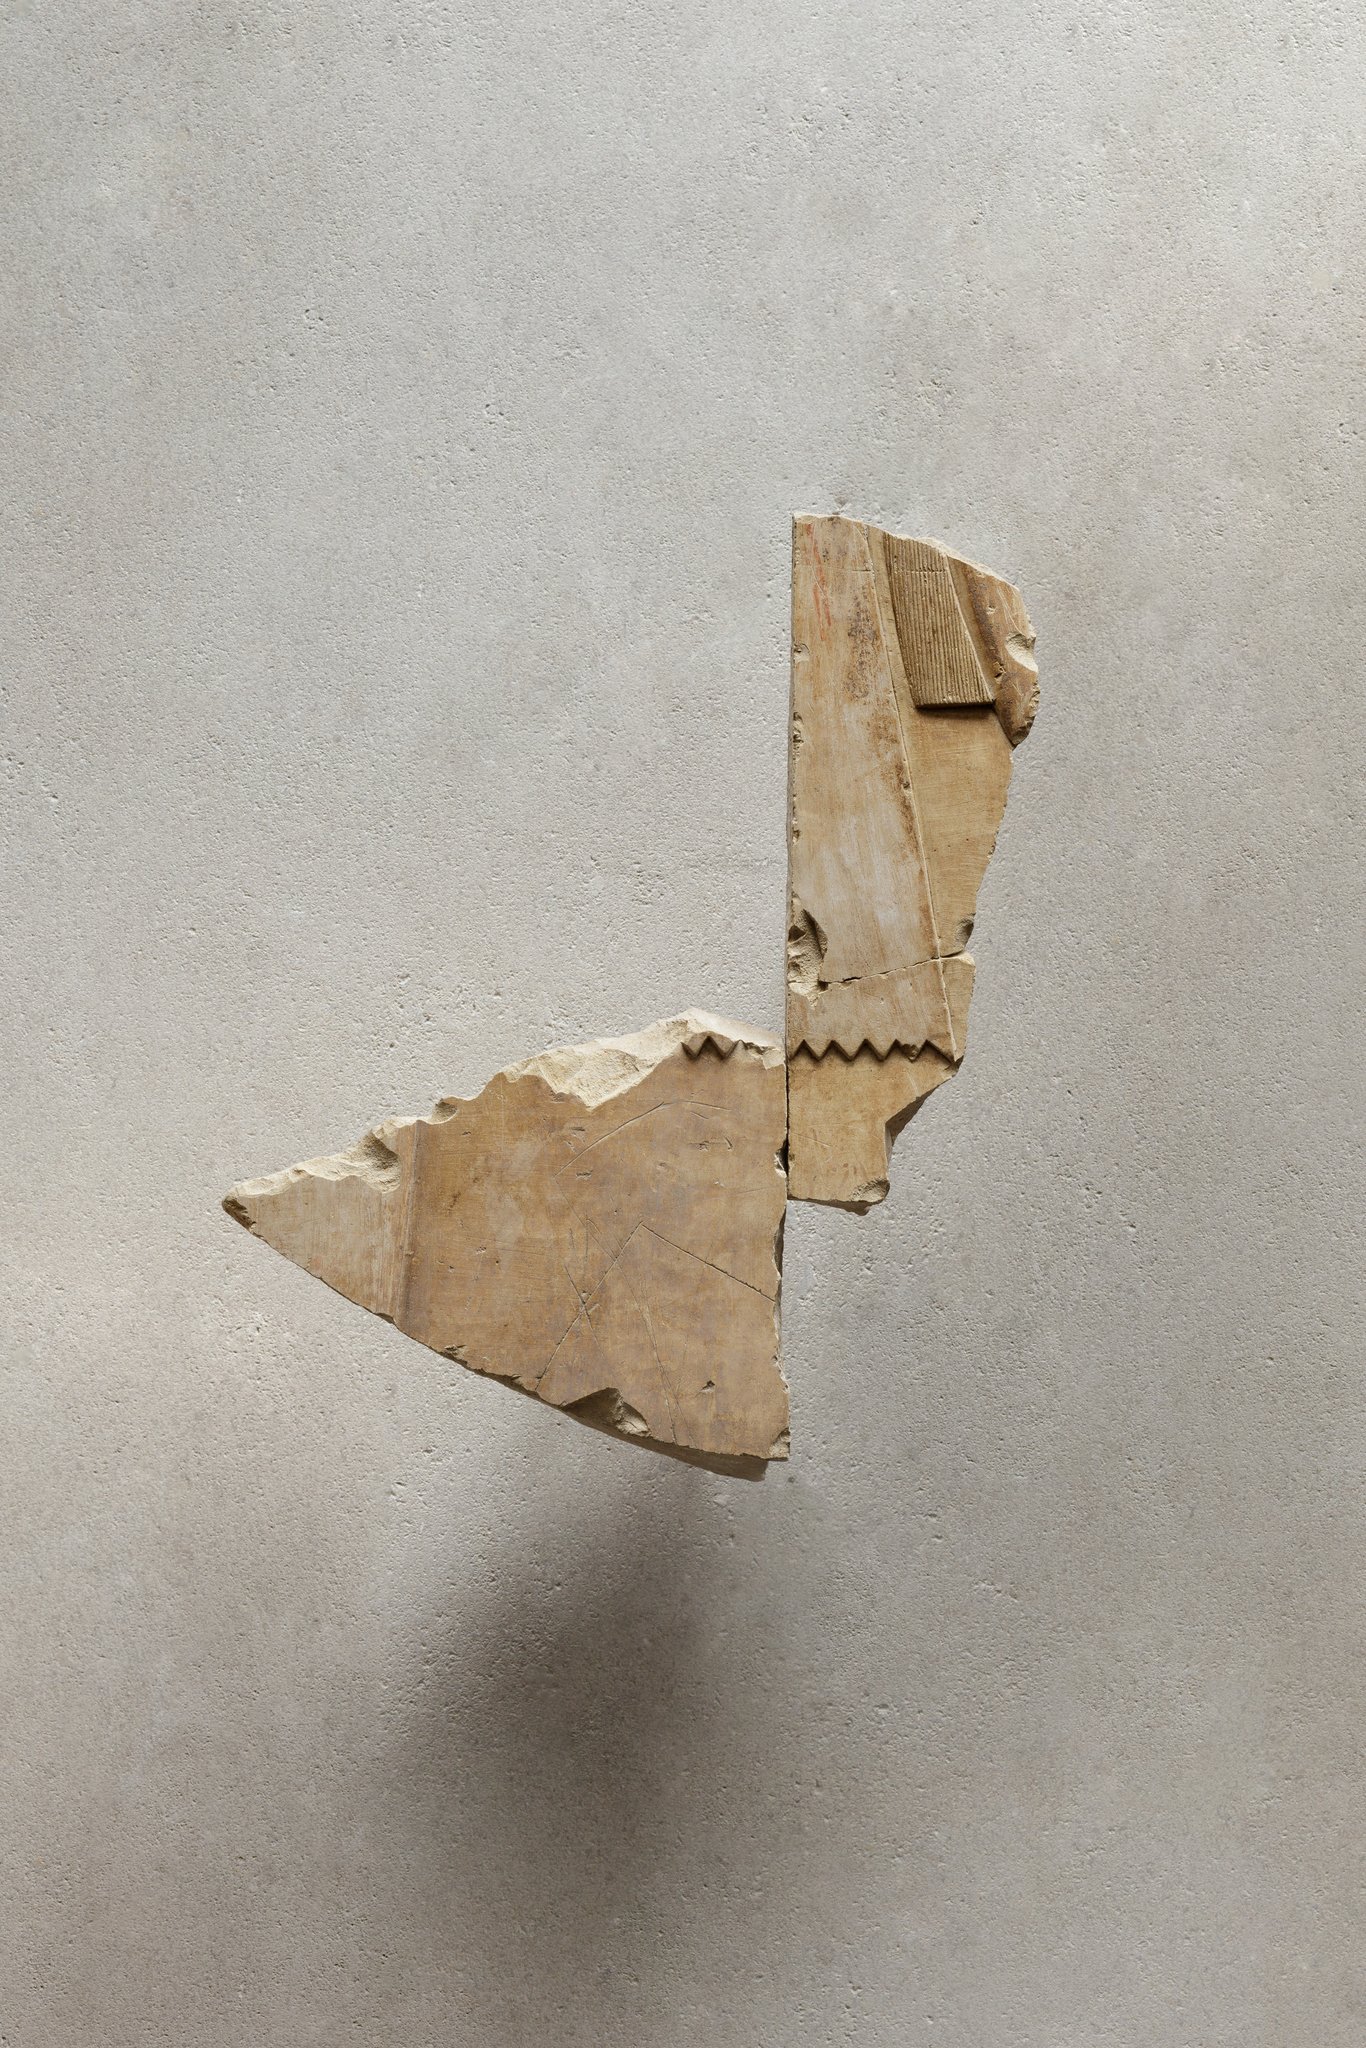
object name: relief fragment, neferu or khety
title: Relief from the tomb of Queen Neferu, part of sunshade (see 26.3.353-1)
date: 2051-2030 BCE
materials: limestone, paint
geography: egypt